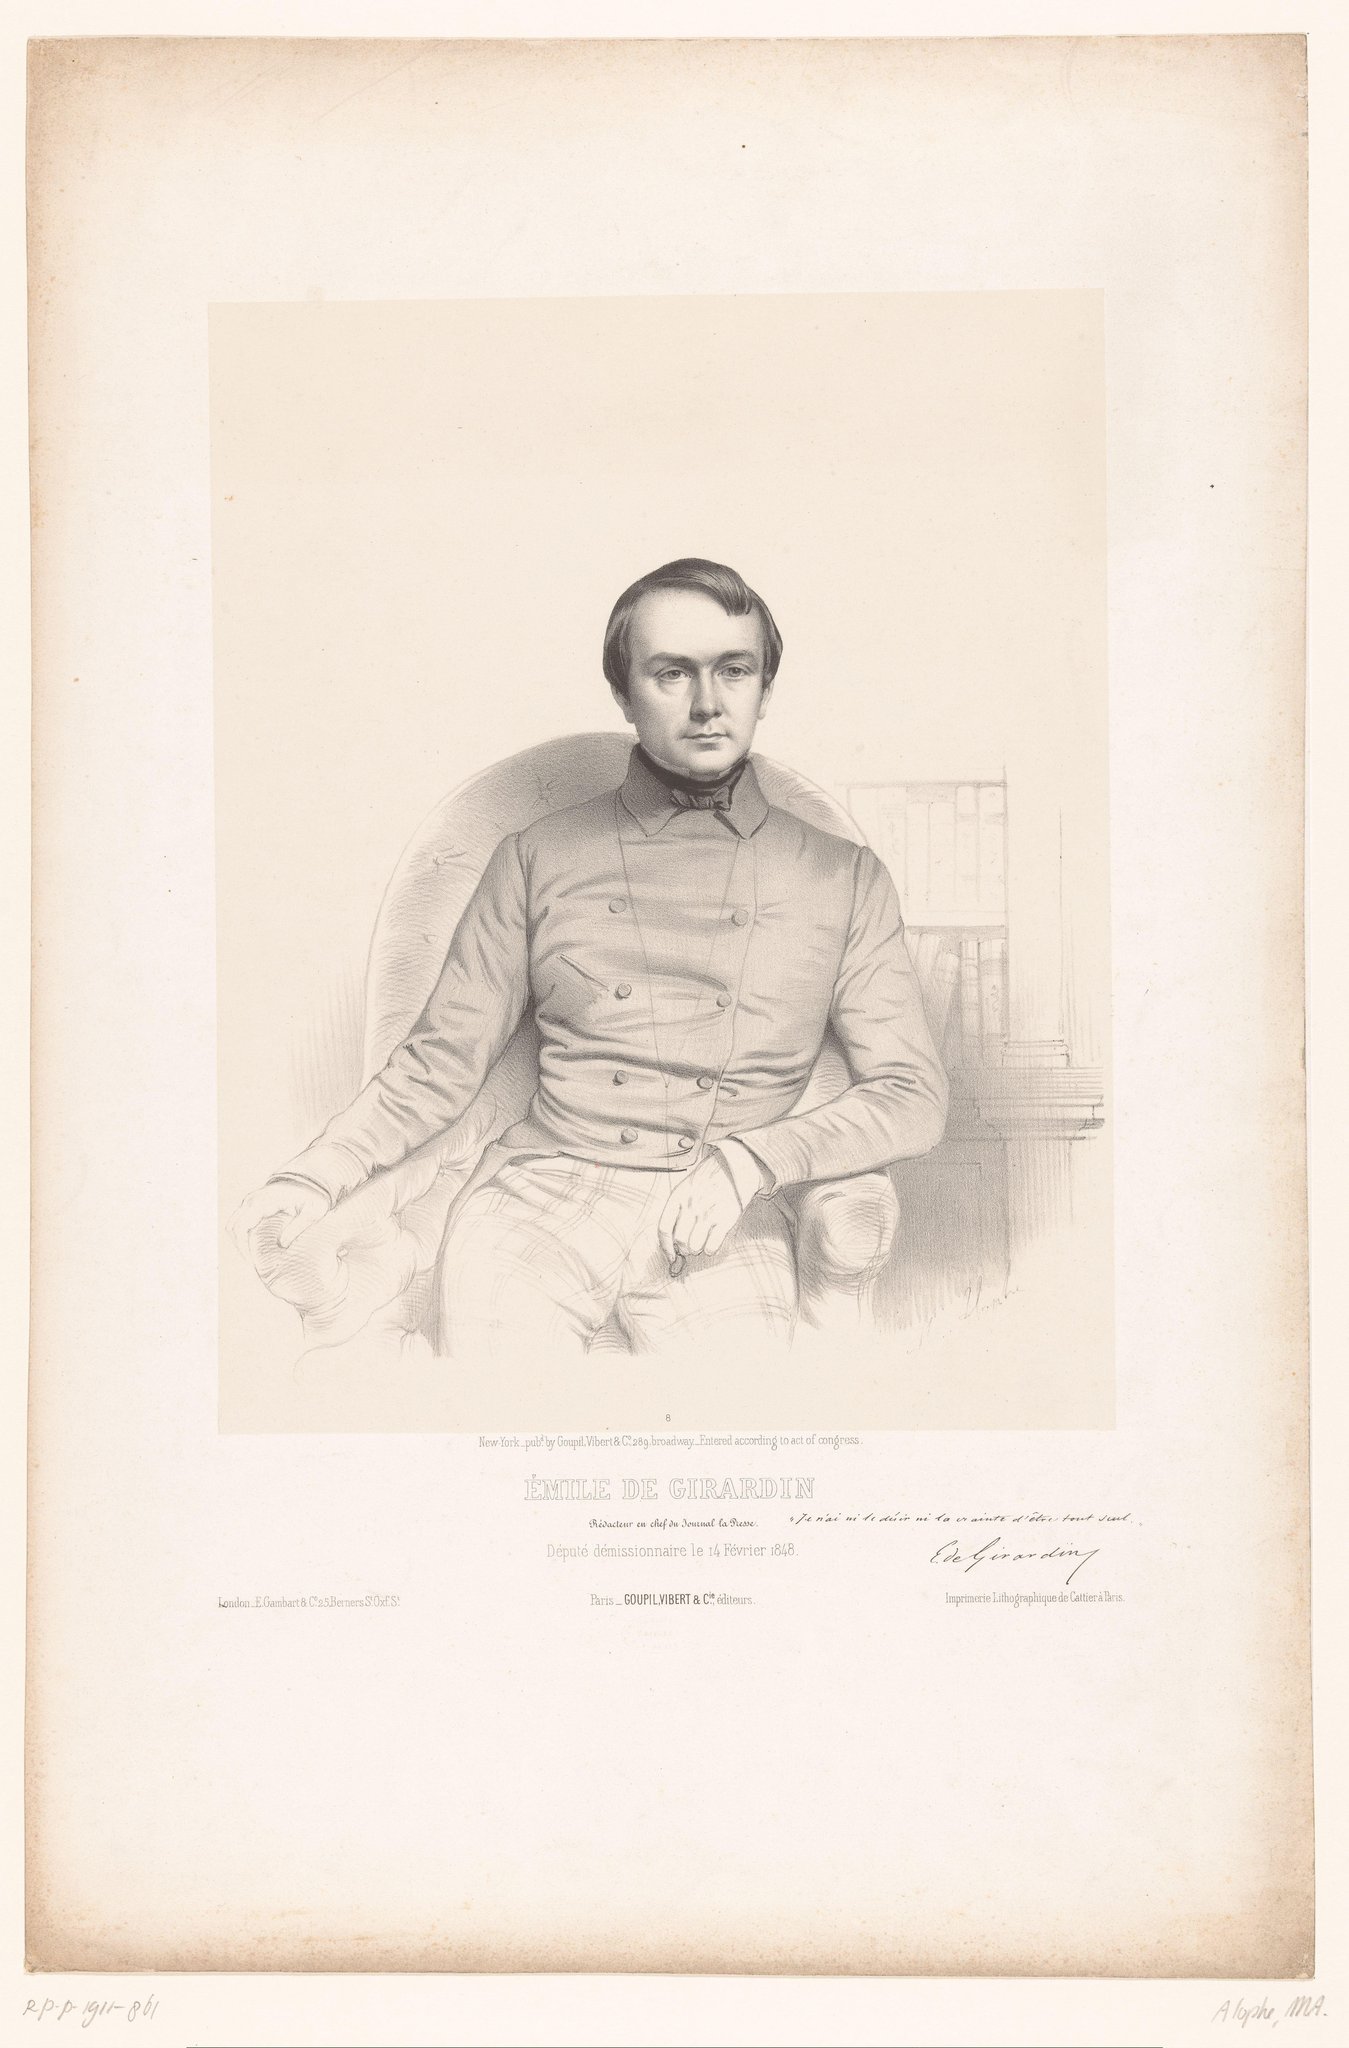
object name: print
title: Émile de Girardin. Rédacteur en chef du journal la presse, député démissionnaire le 14 Février 1848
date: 1848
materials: paper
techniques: lithography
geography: london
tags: politician, émile de girardin, historical persons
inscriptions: check stamp: Lugt 5004, collector's mark: Lugt 2228